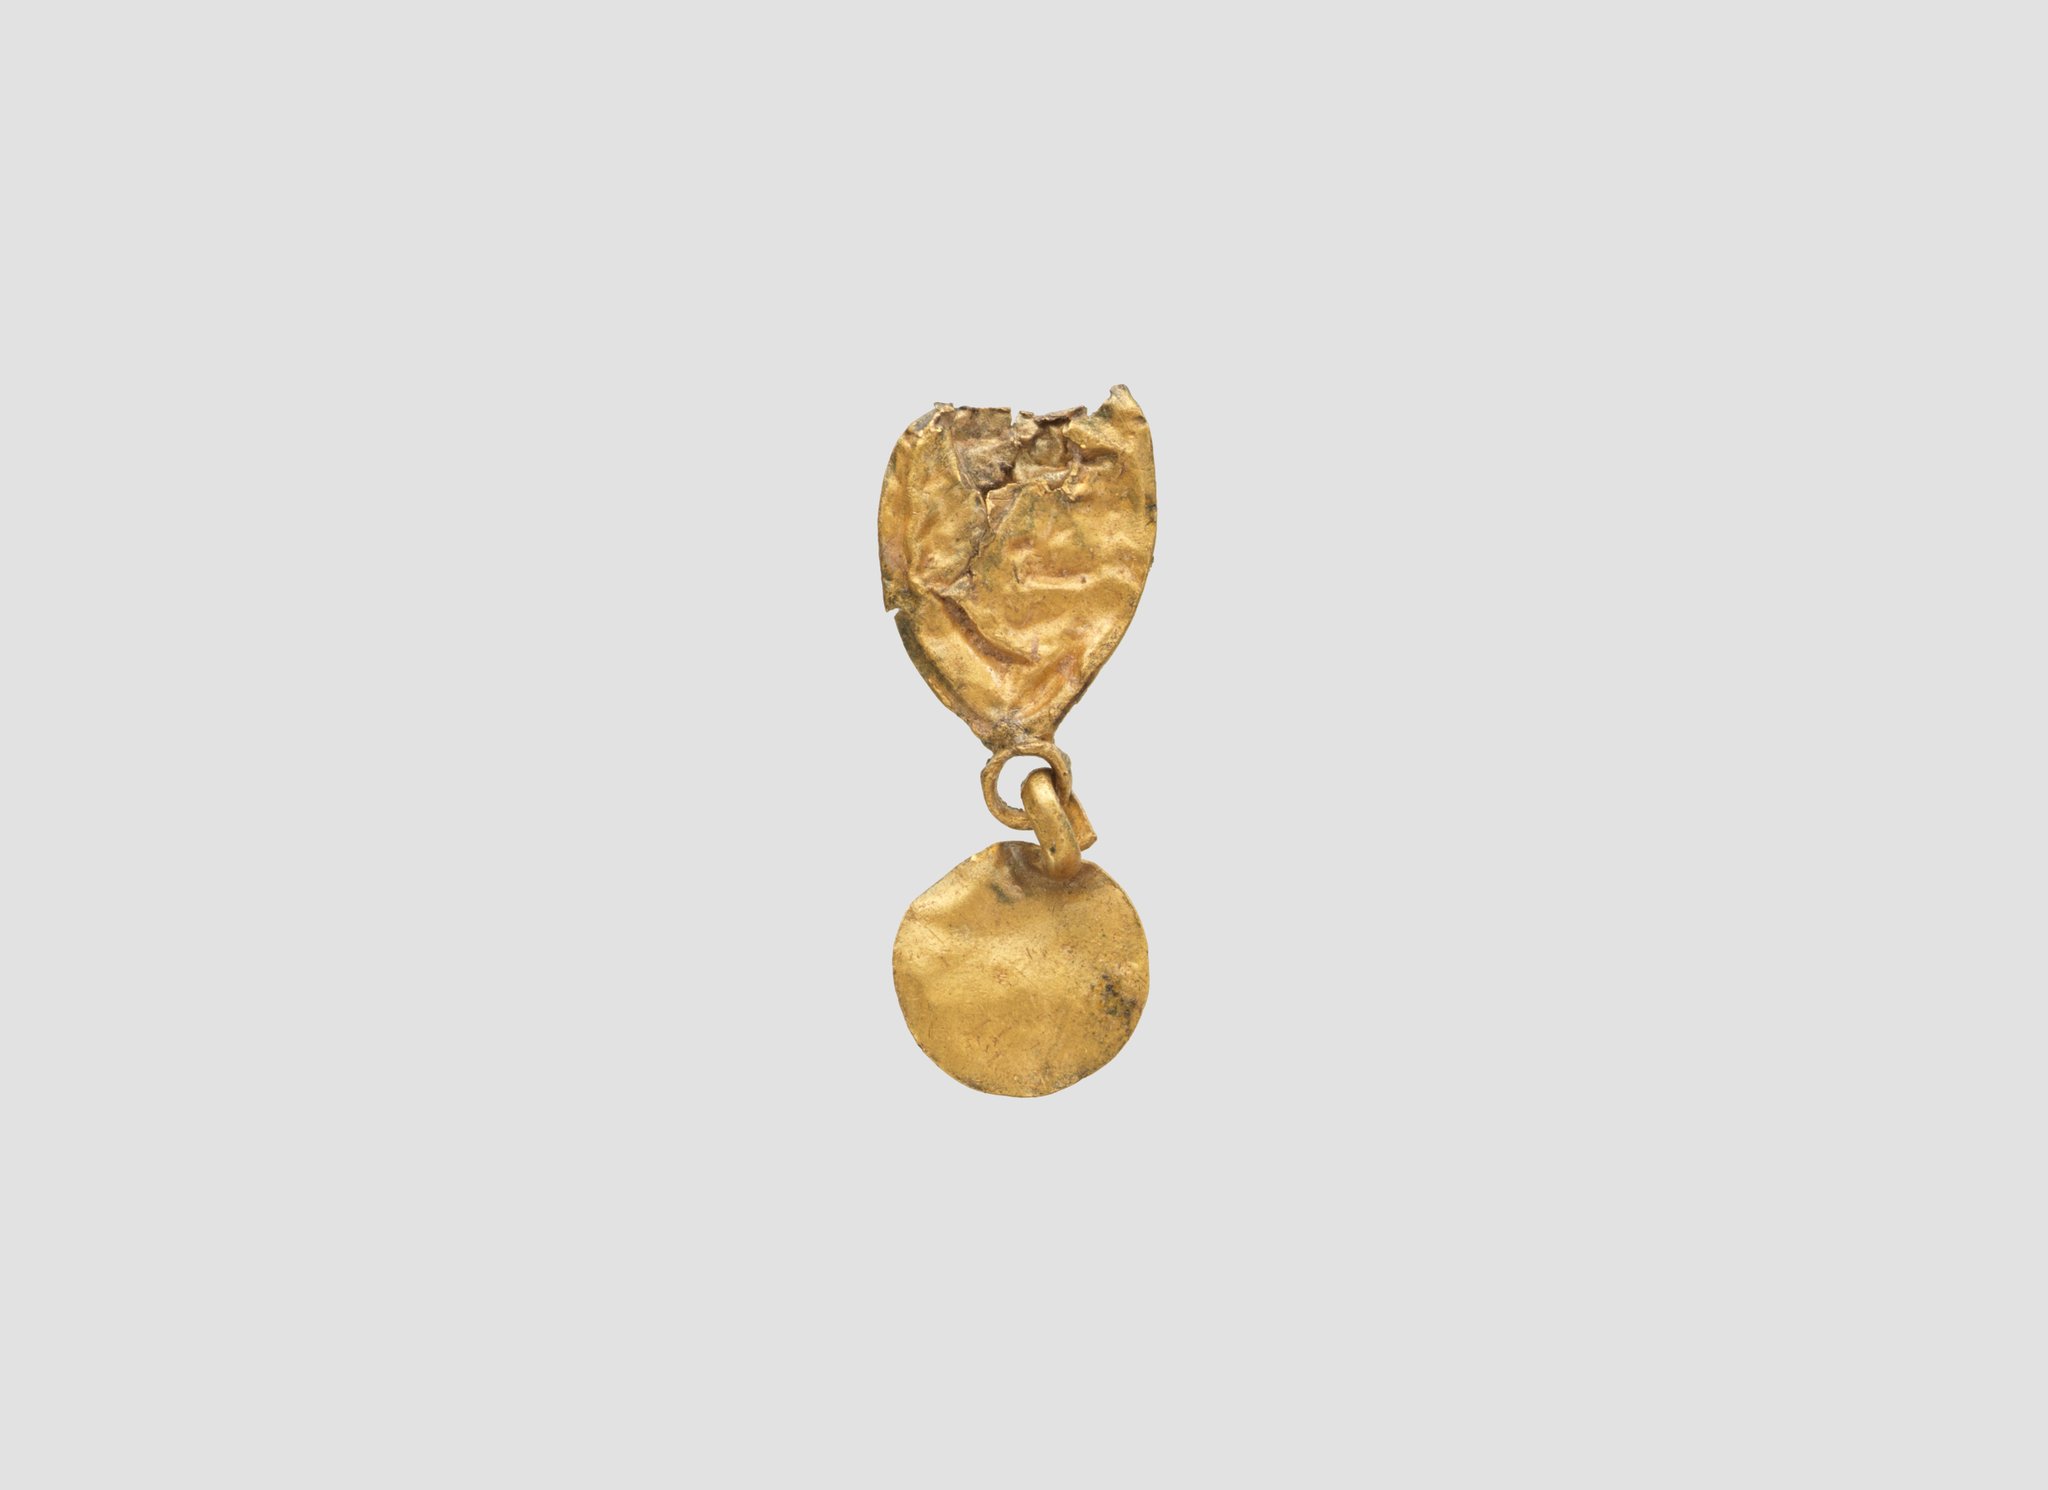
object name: jewellery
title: Jewelry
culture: sasanian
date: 201-700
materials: gold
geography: iran